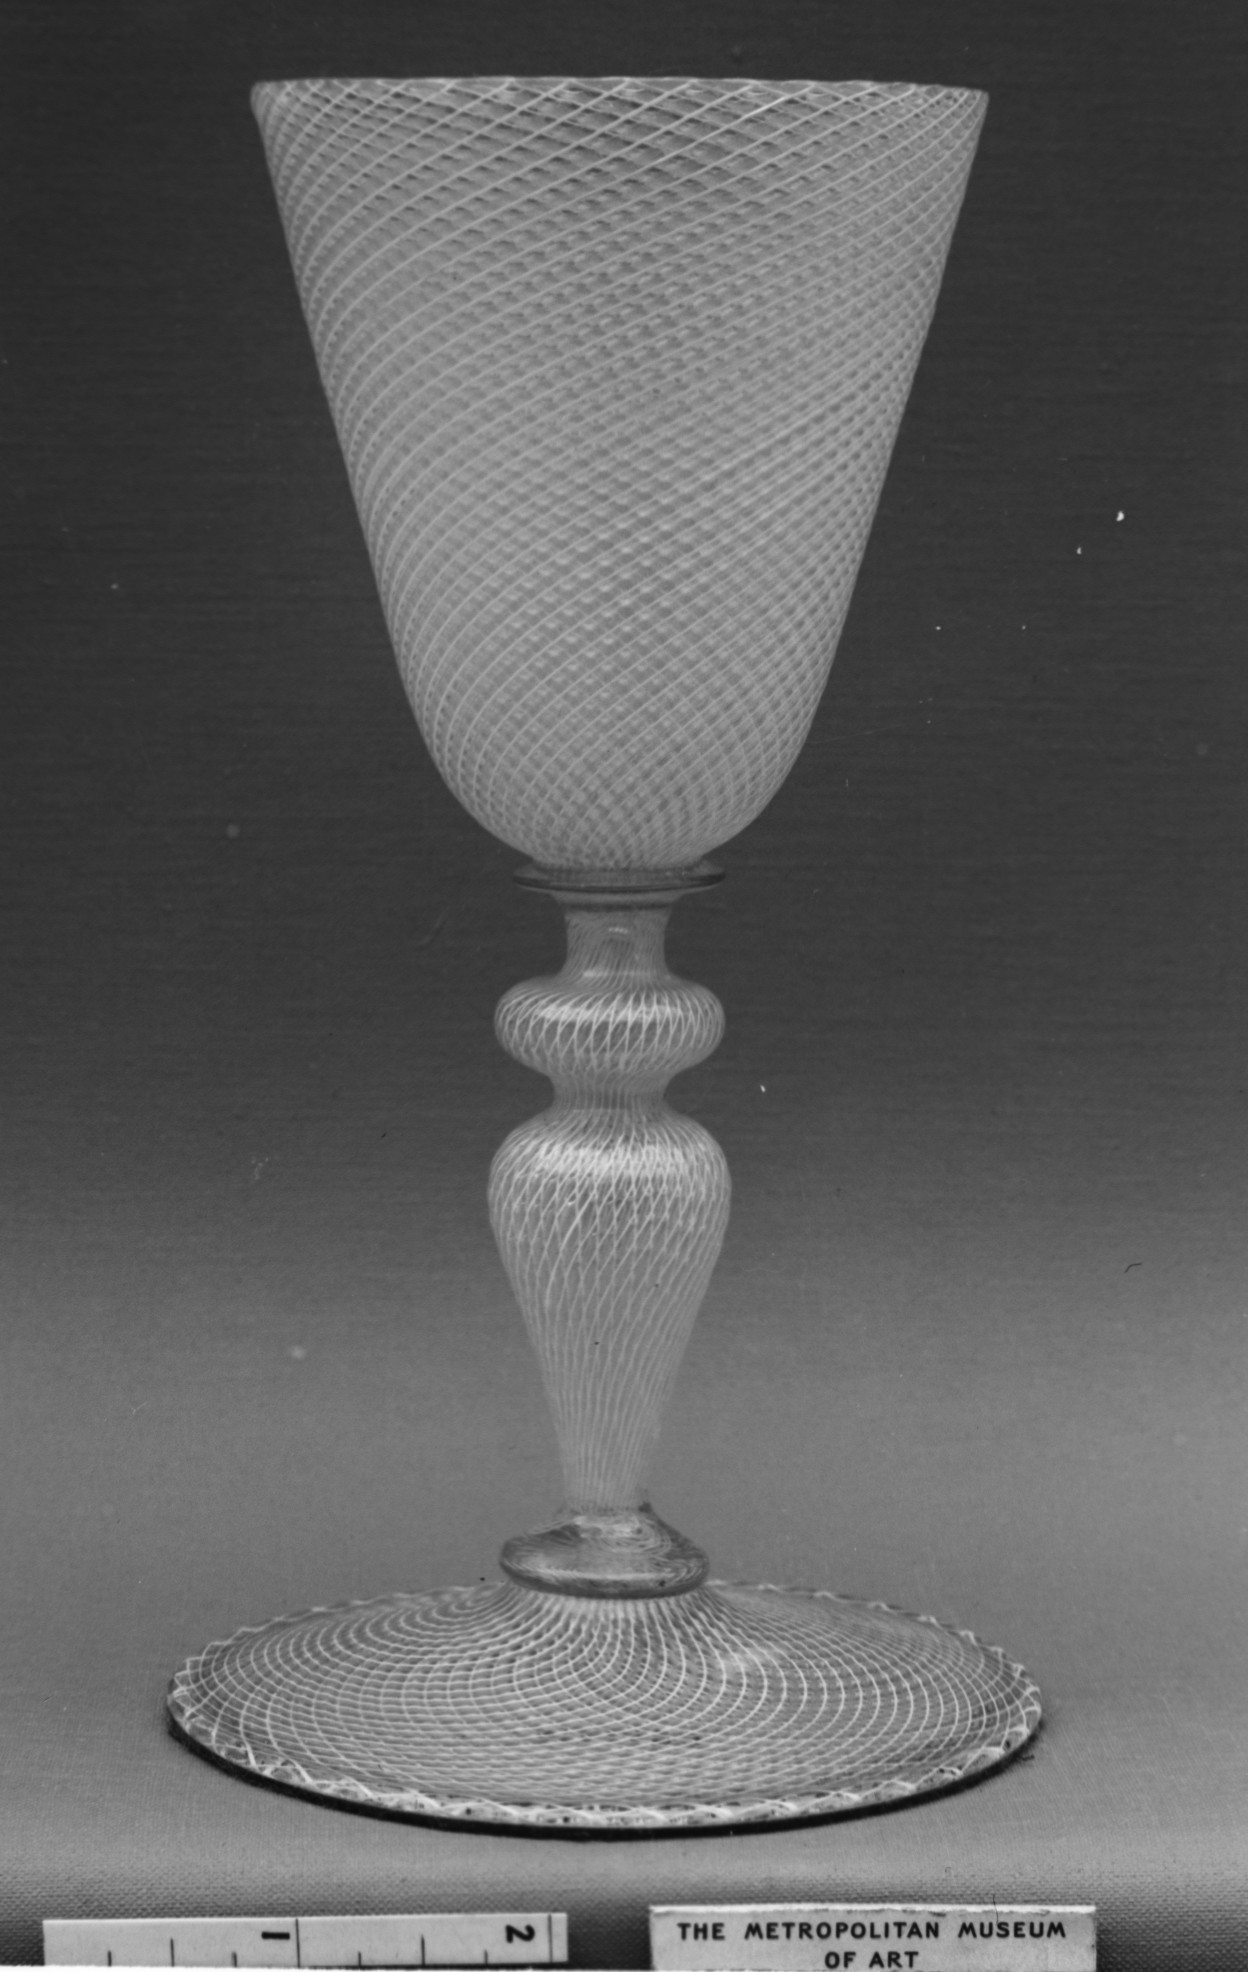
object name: goblet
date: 1601-1700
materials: glass